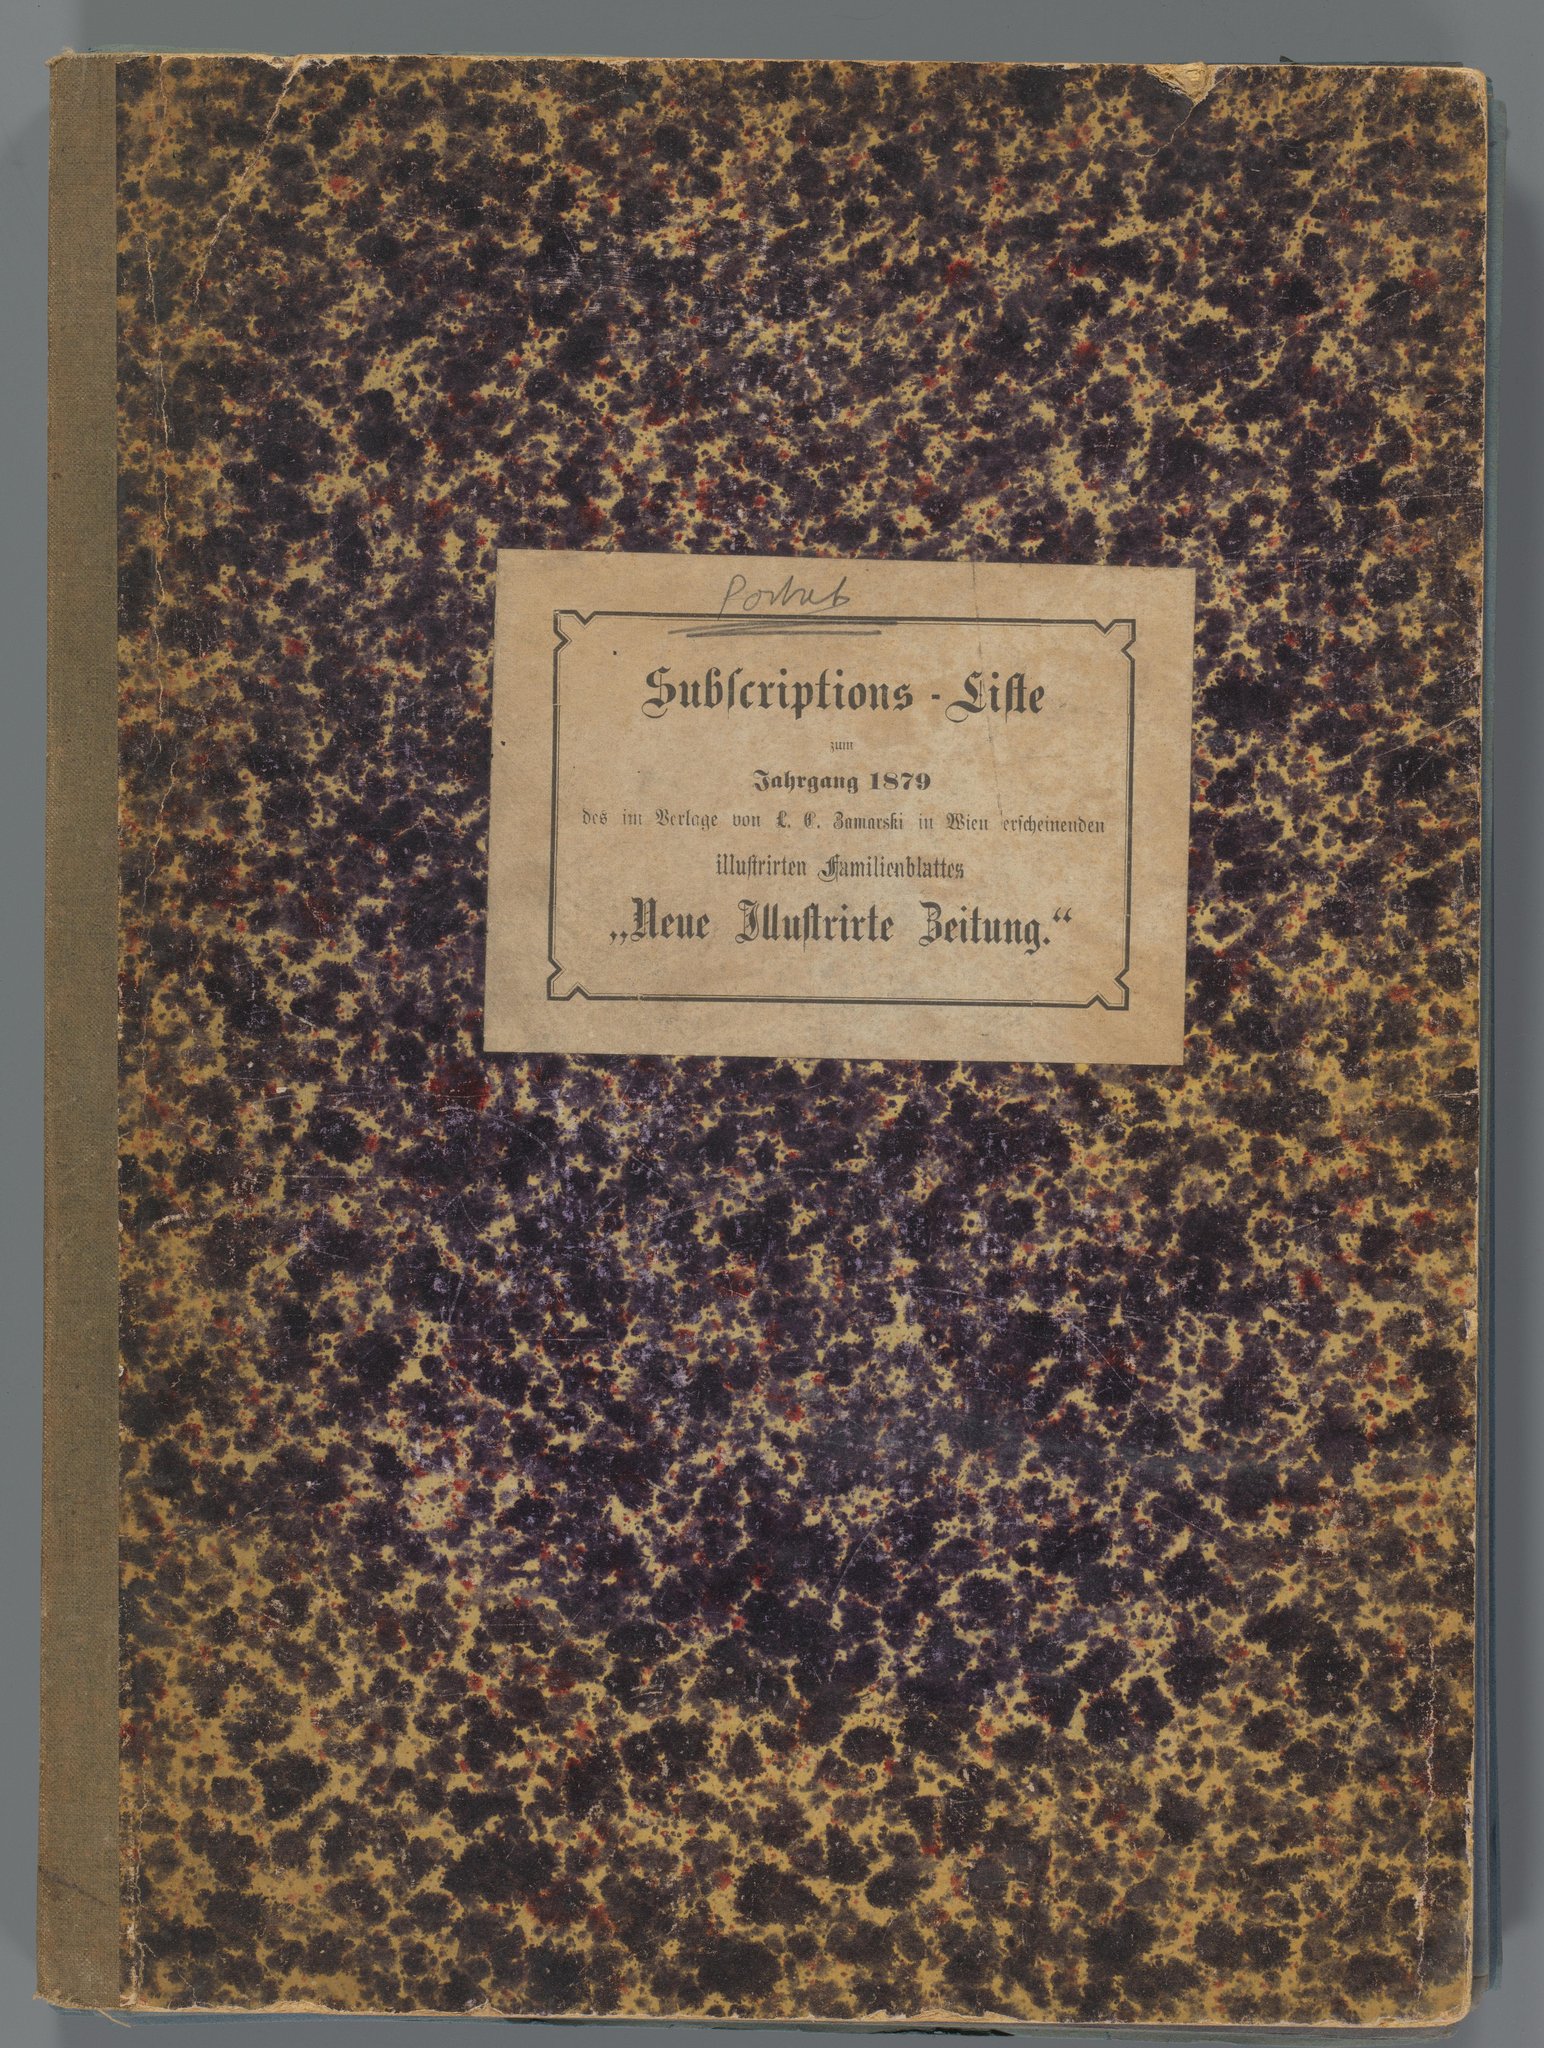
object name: wrapper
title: Omslag voor prenten met portretten op albumbladen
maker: Anonymous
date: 1879-1900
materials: cardboard, paper, textile